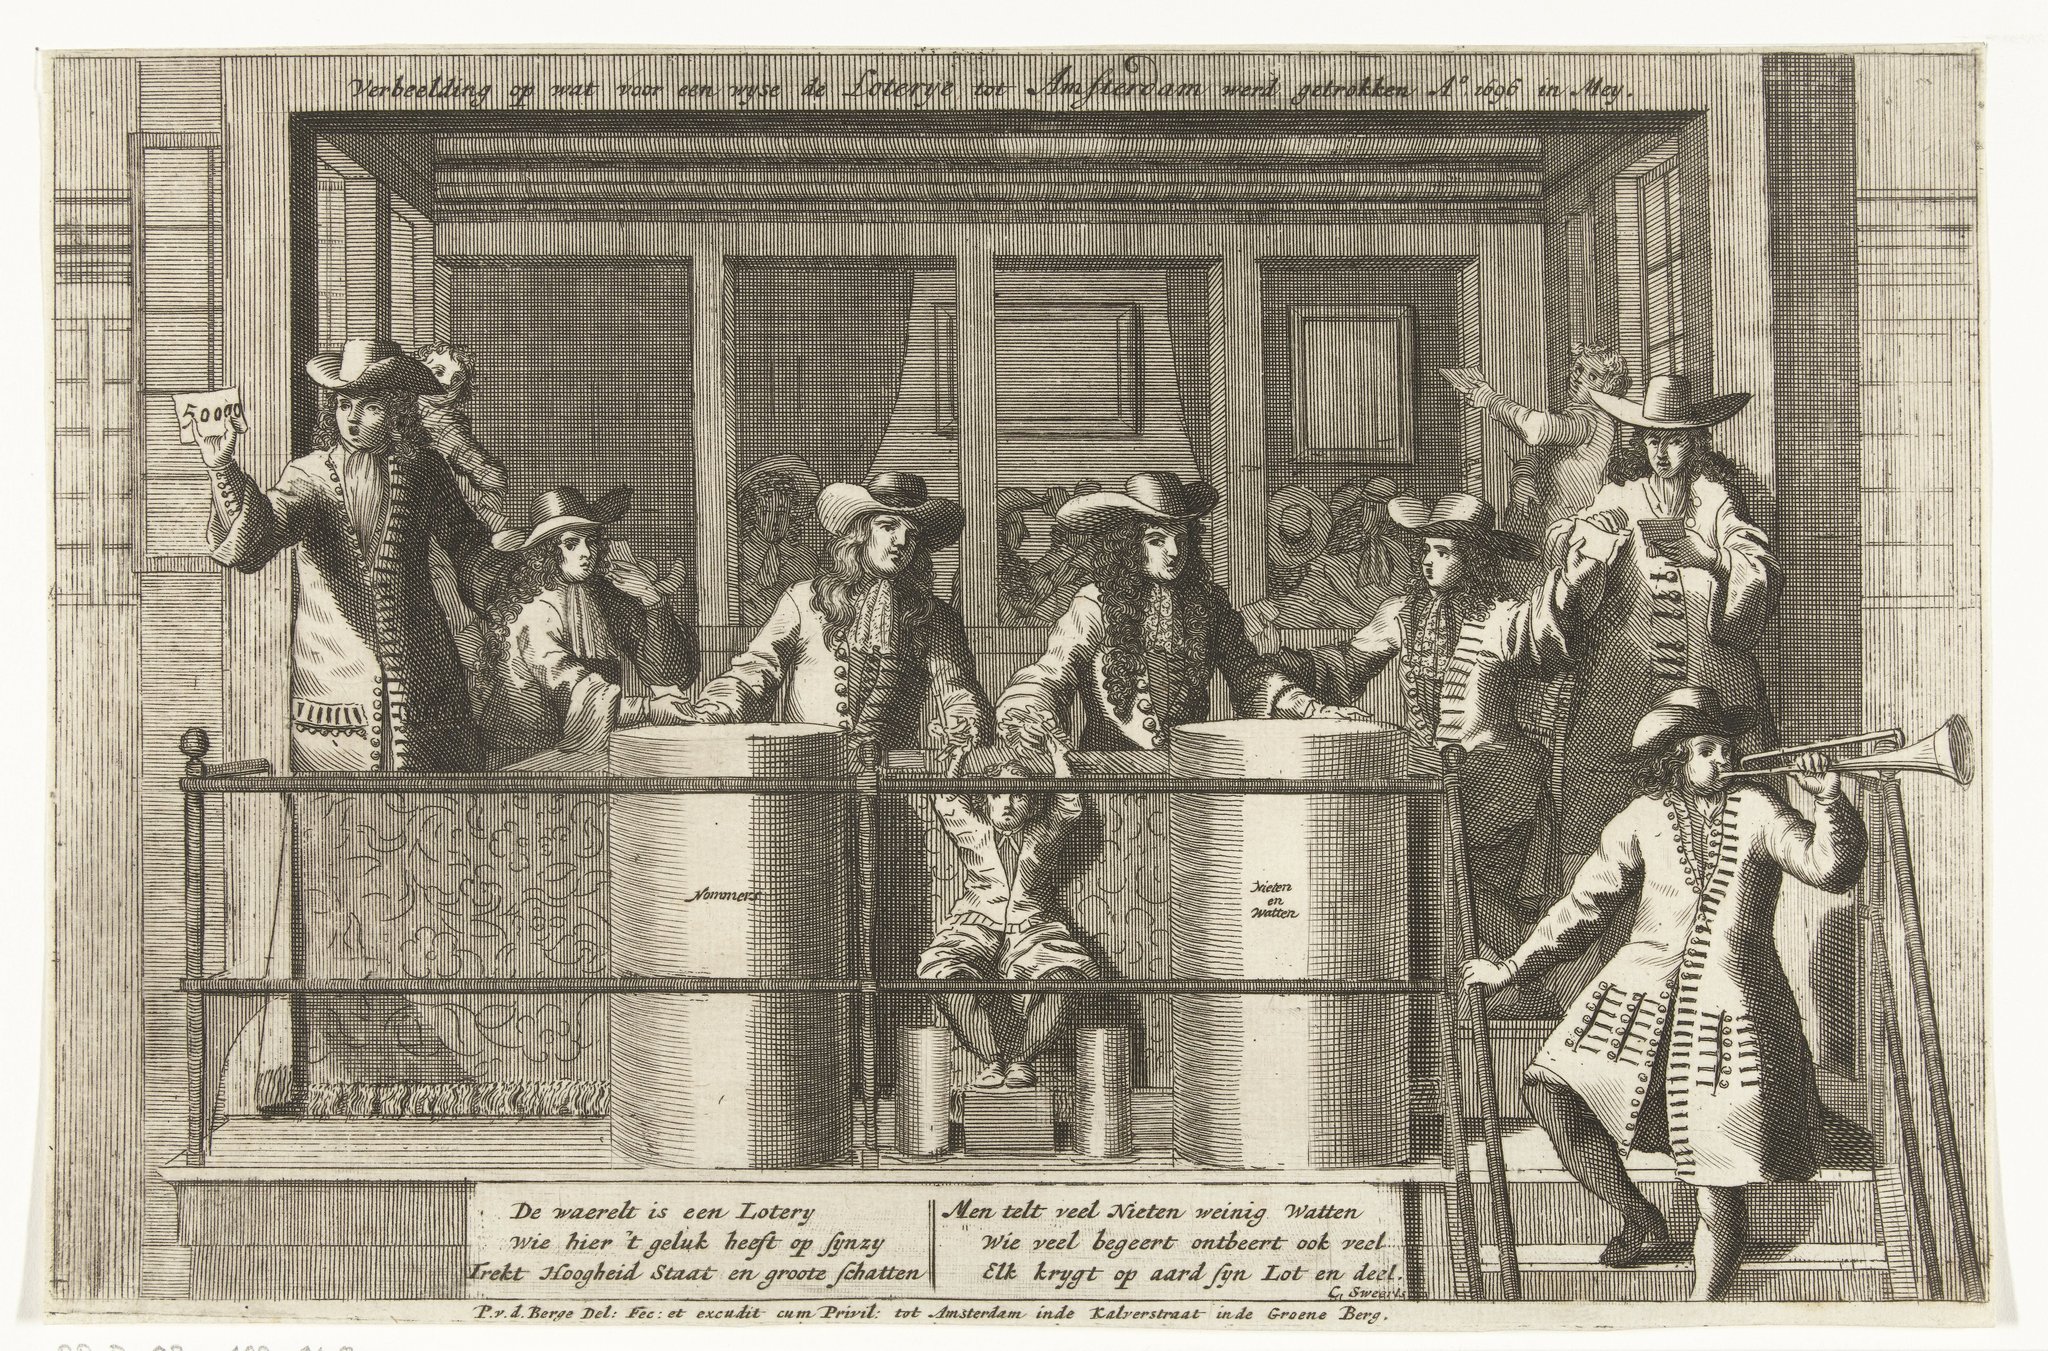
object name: print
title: Verbeelding op wat voor een wyze de Loterye tot Amsterdam werd getrokken Ao. 1696 in Mey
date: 1696-1698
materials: paper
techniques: engraving, etching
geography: amsterdam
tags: raffle, lottery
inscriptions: collector's mark: Lugt 2228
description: Op een open gallerij staan twee grote vaten. Rechts de Nieten en Watten, links de Nommers. Een jongetje trekt uit elk een lot en geeft deze naar achteren door. Hier worden de winnaars opgeschreven en uitgeroepen. Onder de voorstelling een vers in twee kolommen van elk drie regels op de wereld als lotterij door Sweerts.